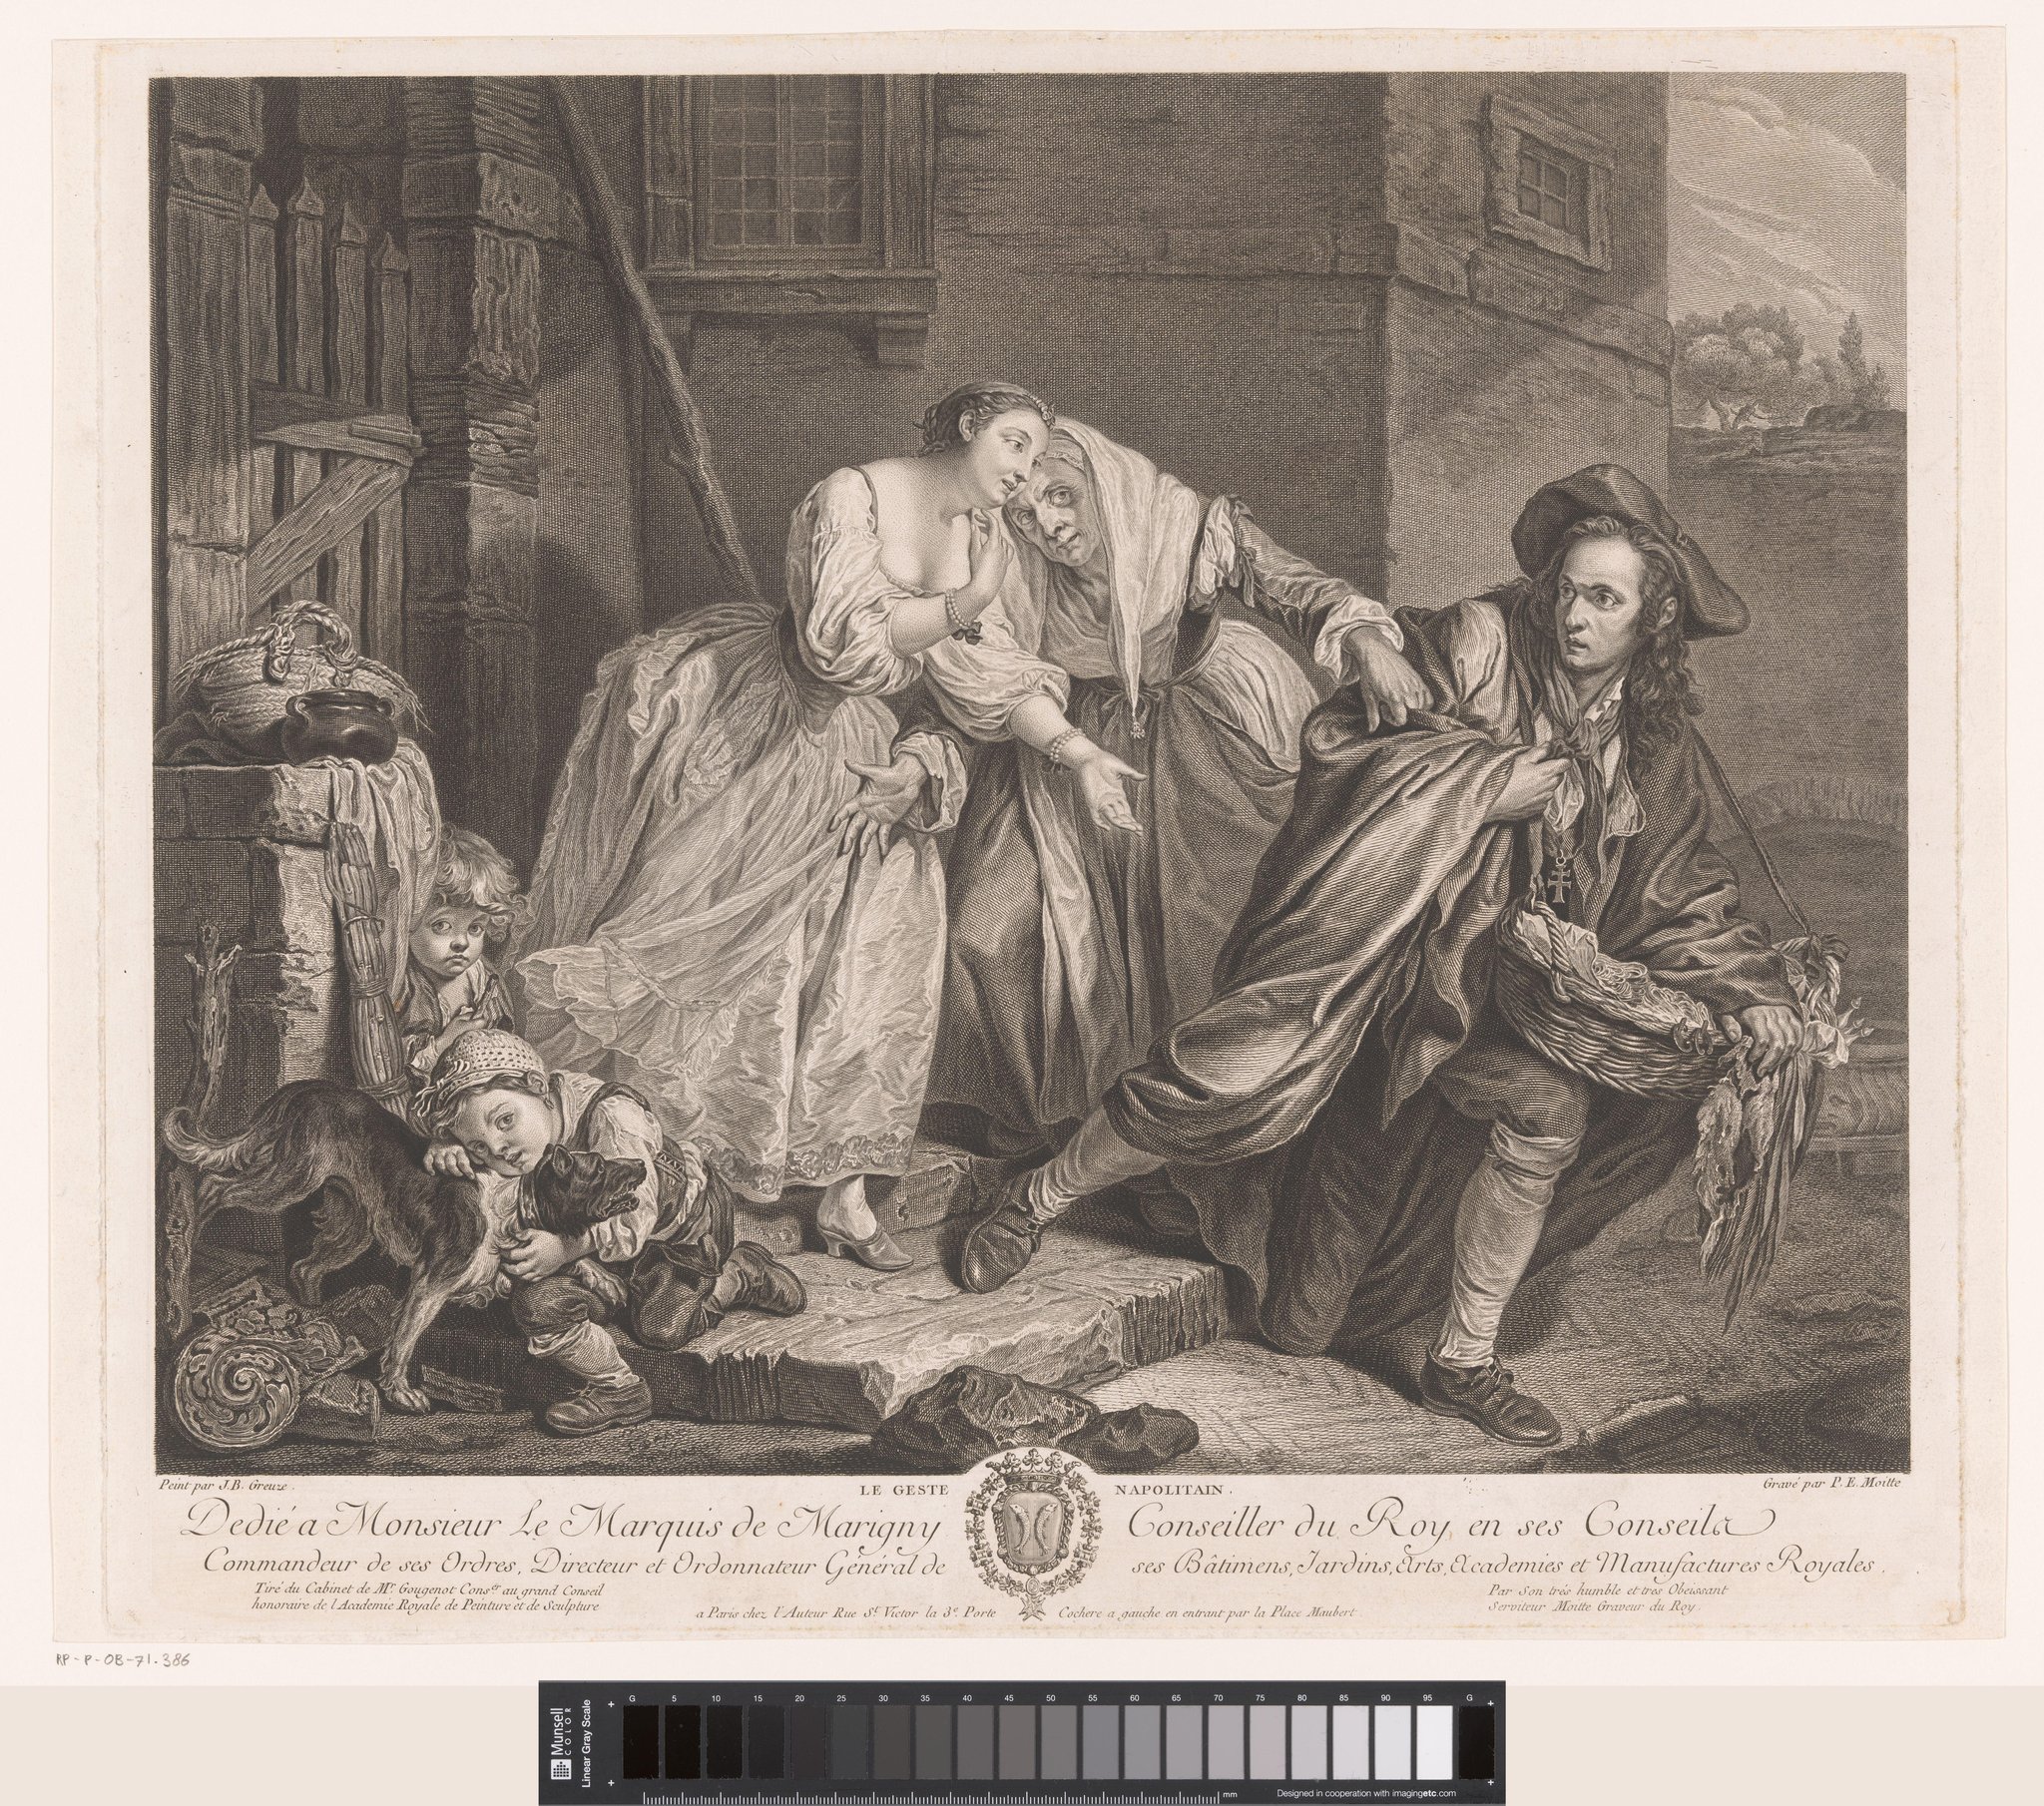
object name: print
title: Le Geste Napolitain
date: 1757-1780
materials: paper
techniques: engraving, etching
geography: paris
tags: gesture-language, rejection, pedlar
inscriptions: collector's mark: Lugt 240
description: Een jonge en oude vrouw staan voor een huis met twee jonge kinderen en een hond. De oude vrouw heeft haar hand op de schouder van een vertrekkende marskramer. De jonge vrouw houdt haar linkerhand onder haar kin en maakt een 'napoleontisch gebaar' (la geste napolitain) dat symbool staat voor afwijzing.